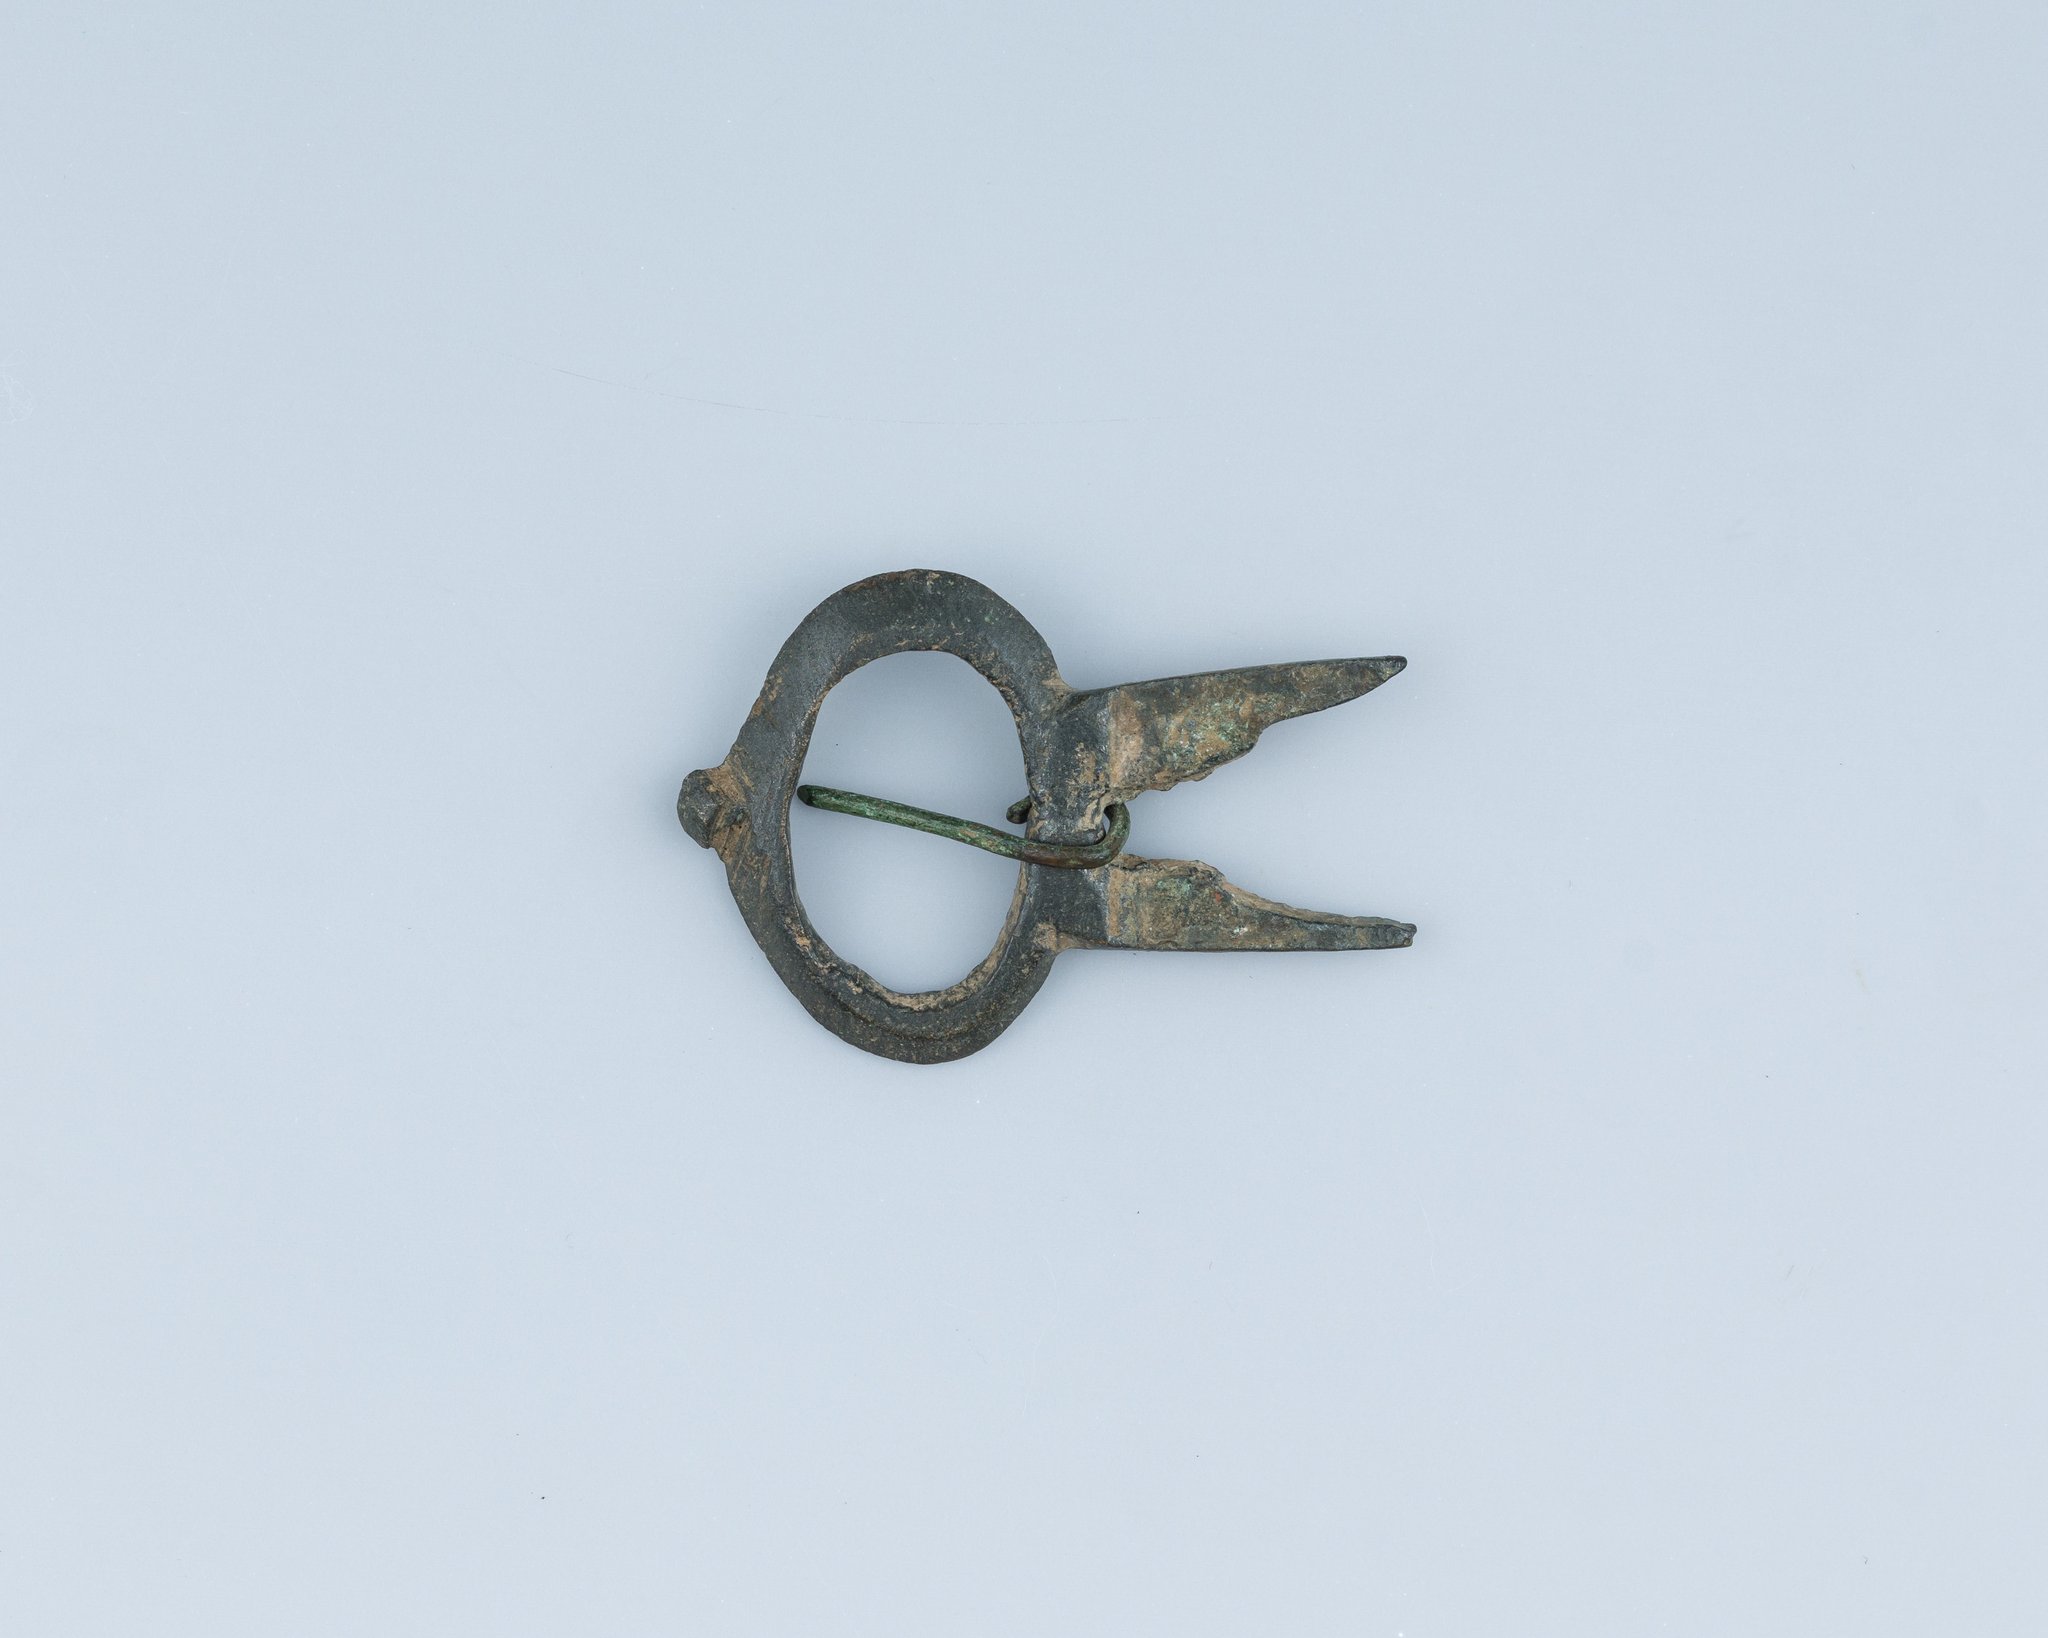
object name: buckle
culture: european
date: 1401-1600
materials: bronze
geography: germany